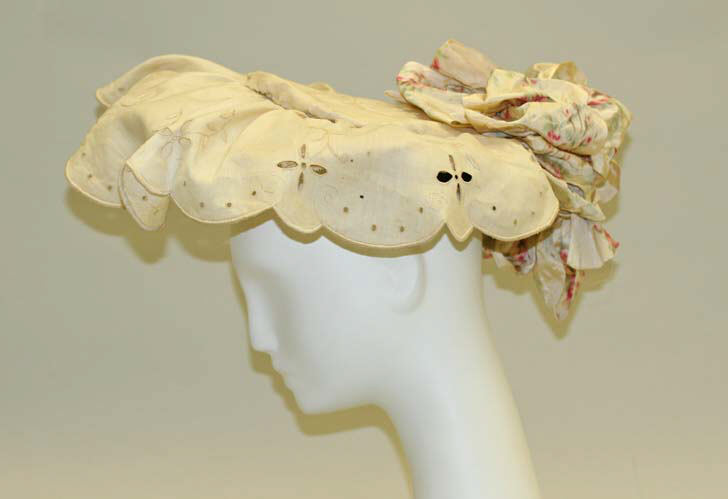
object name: hat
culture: american or european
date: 1895-1905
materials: cotton, linen, silk